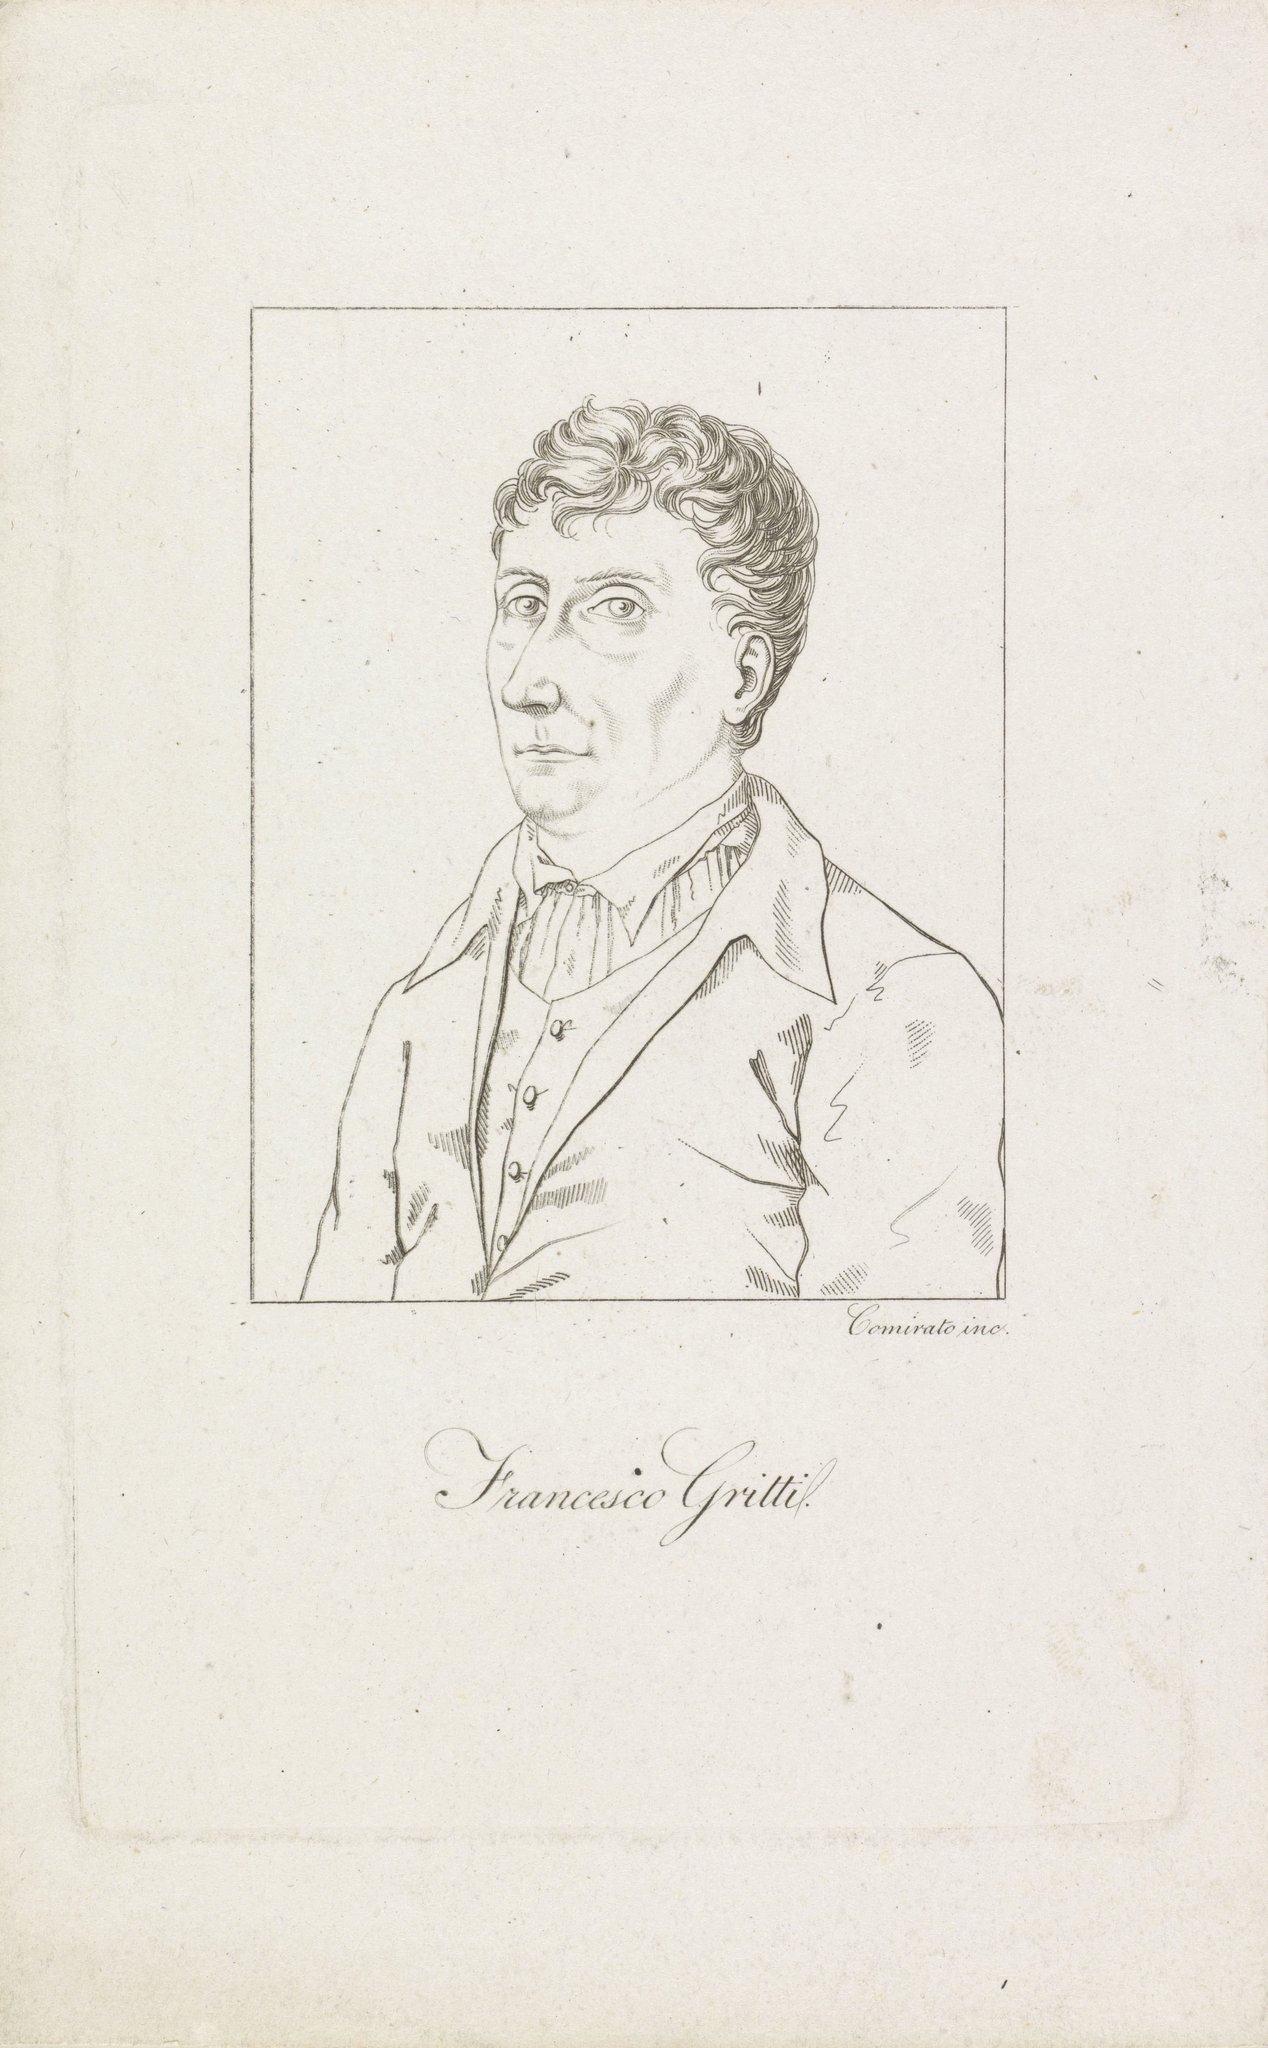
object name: print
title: Portret van dichter Francesco Gritti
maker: marco comirato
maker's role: print maker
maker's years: 1800-1869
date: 1810-1869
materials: paper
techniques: engraving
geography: italy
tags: venice, historical persons, portrait of a writer, writer, poet, author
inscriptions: collector's mark: Lugt 2228